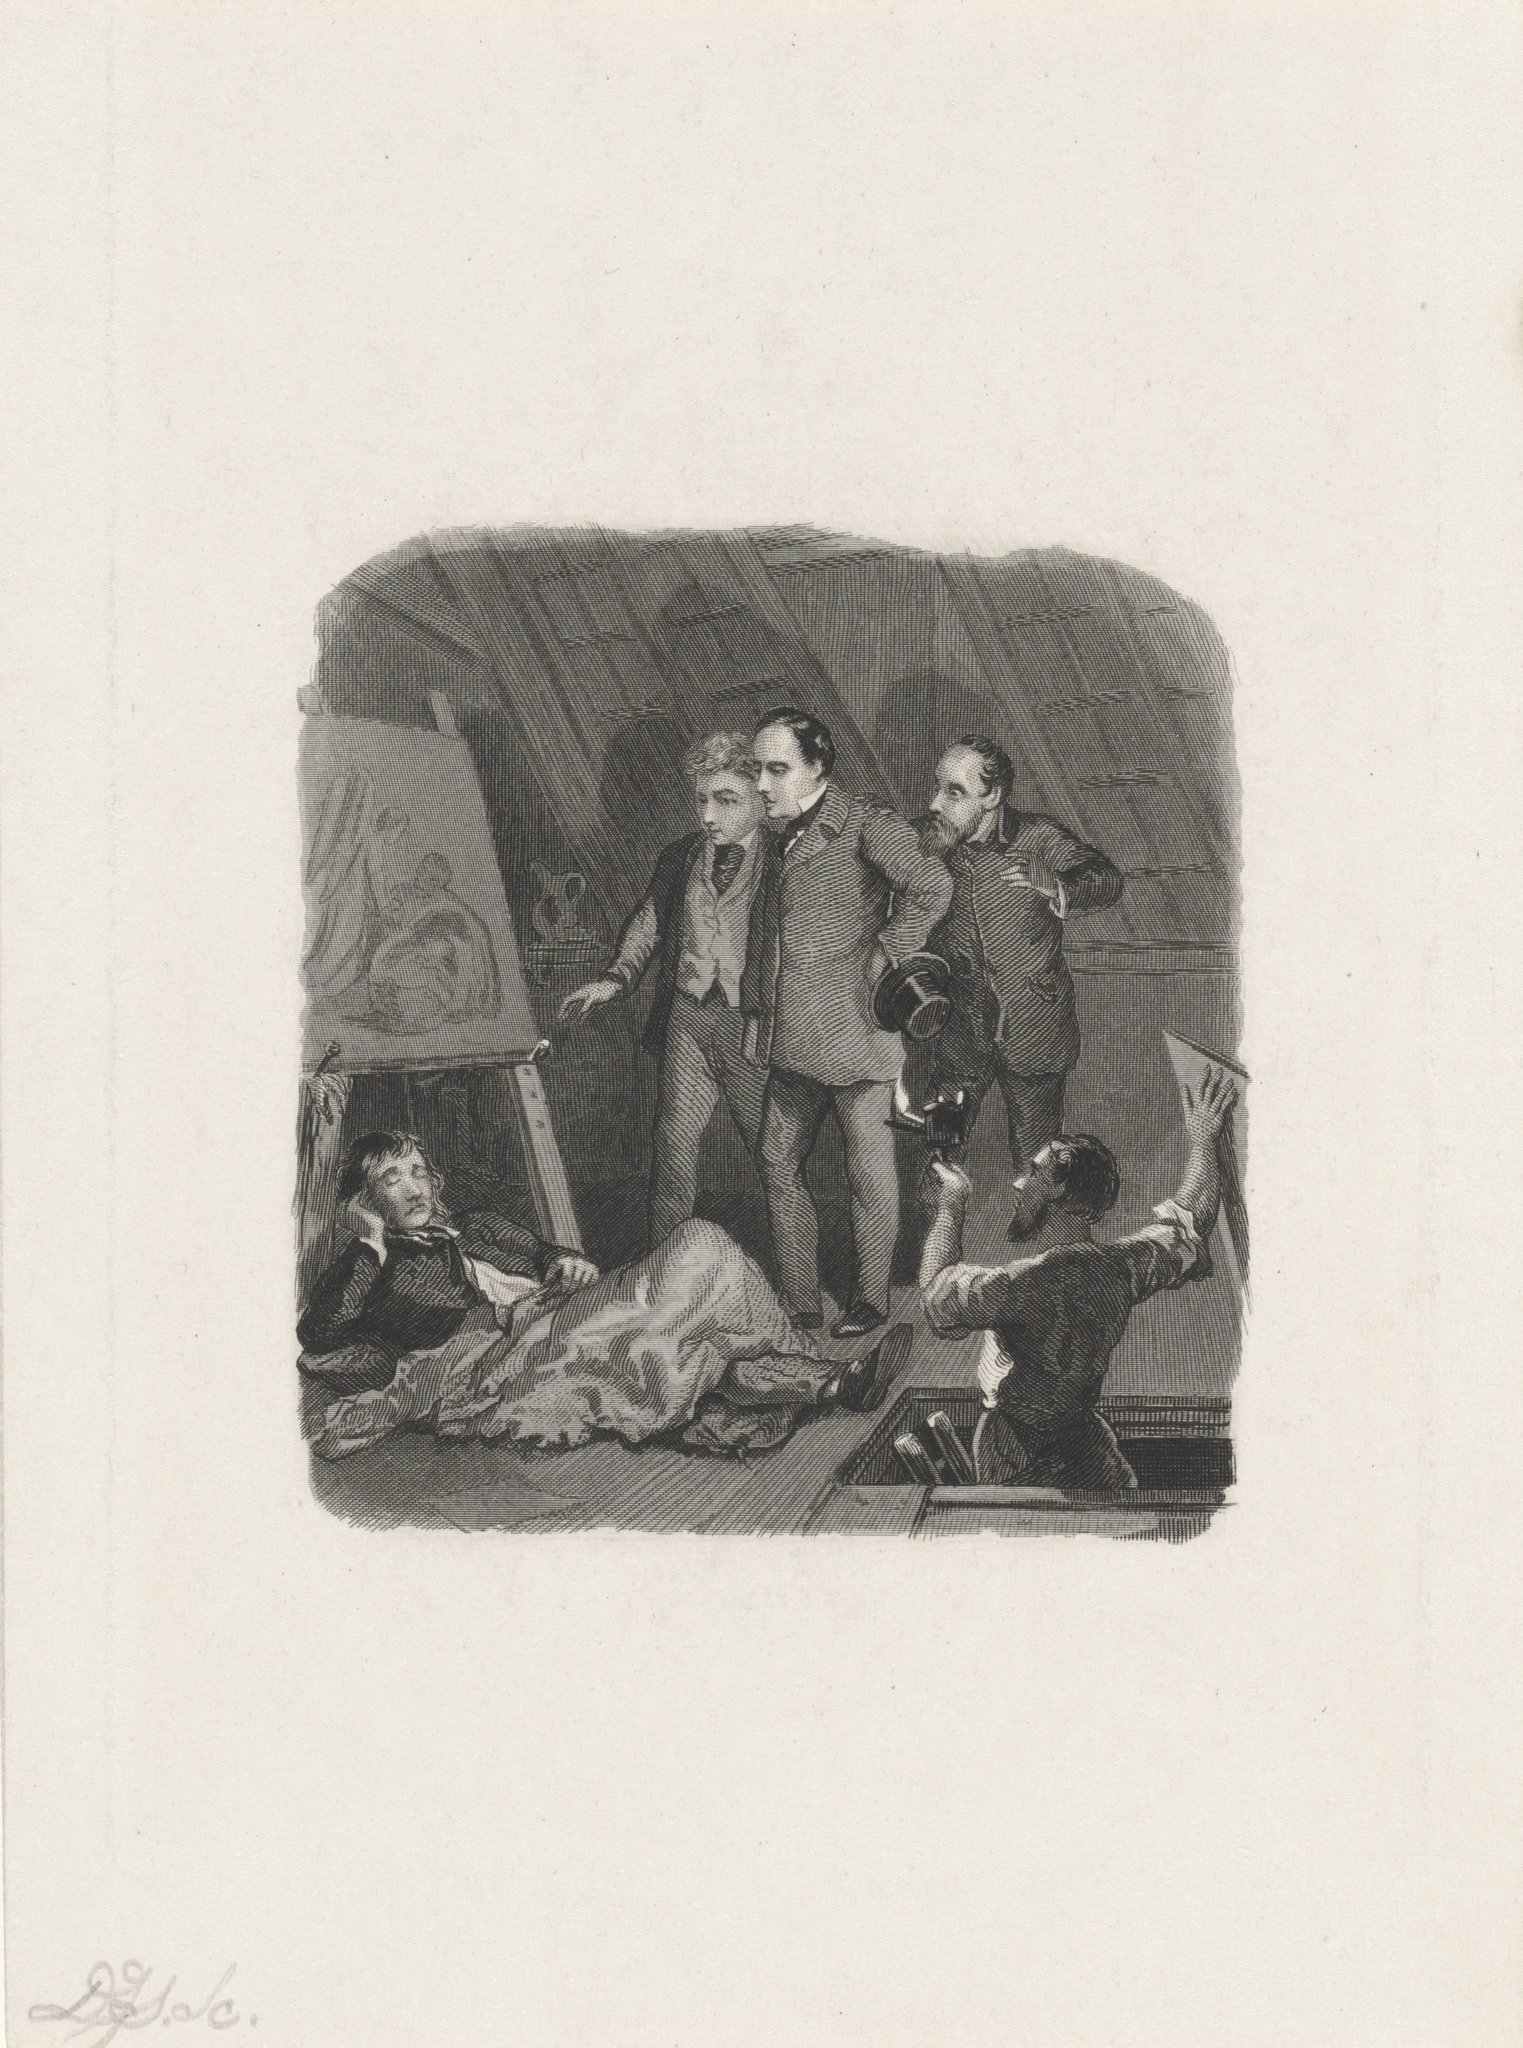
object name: print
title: Slapende schilder betrapt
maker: dirk jurriaan sluyter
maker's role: draughtsman, print maker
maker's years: 1811-1886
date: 1826-1886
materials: paper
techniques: engraving, etching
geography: amsterdam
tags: sleeping on the ground, easel, painter in non-work situation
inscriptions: collector's mark: Lugt 2228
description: Op een zolderkamer kijken drie mannen neer op een schilder, die op de grond tegen zijn ezel ligt te slapen met een deken over zich heen. Vanaf een ladder kijkt een vierde man met een lamp toe terwijl hij met een hand het vlieringluik open houdt.